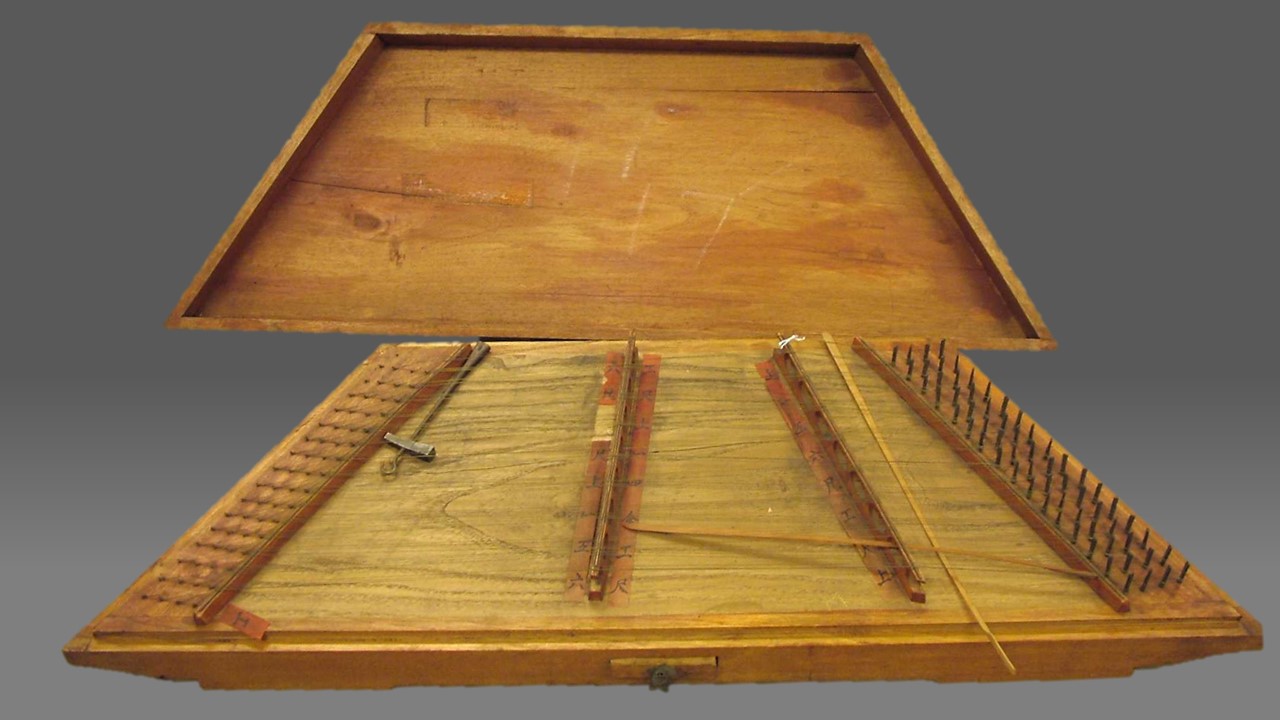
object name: yangqin 揚琴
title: Yangqin (揚琴)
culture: chinese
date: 1801-1900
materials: bamboo, metal, wood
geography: china